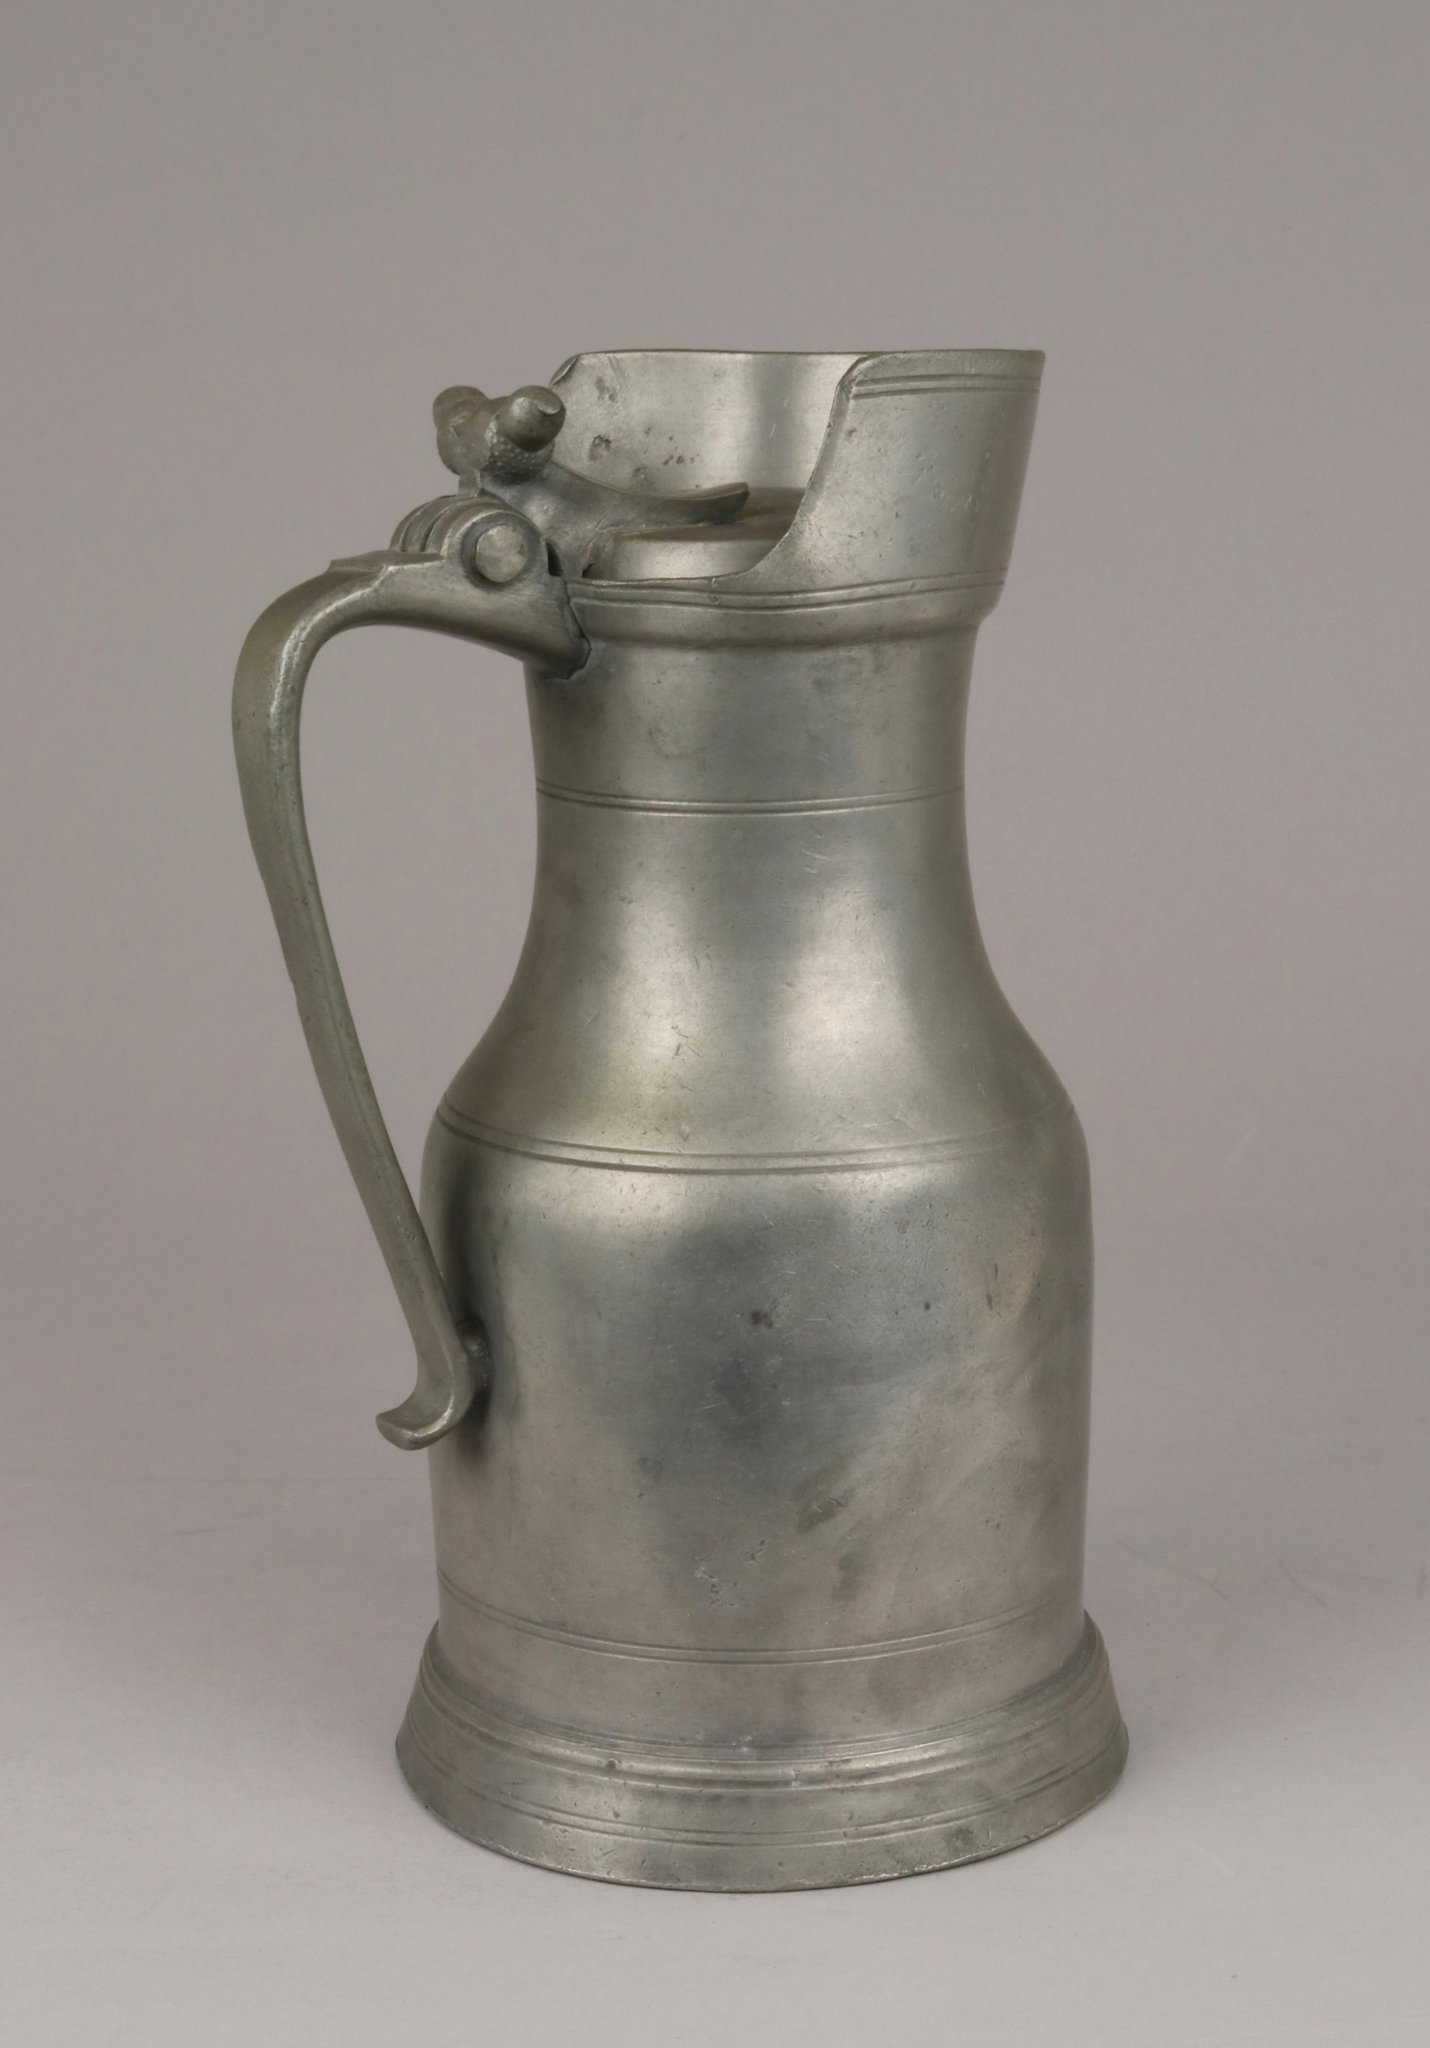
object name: flagon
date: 1701-1800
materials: pewter